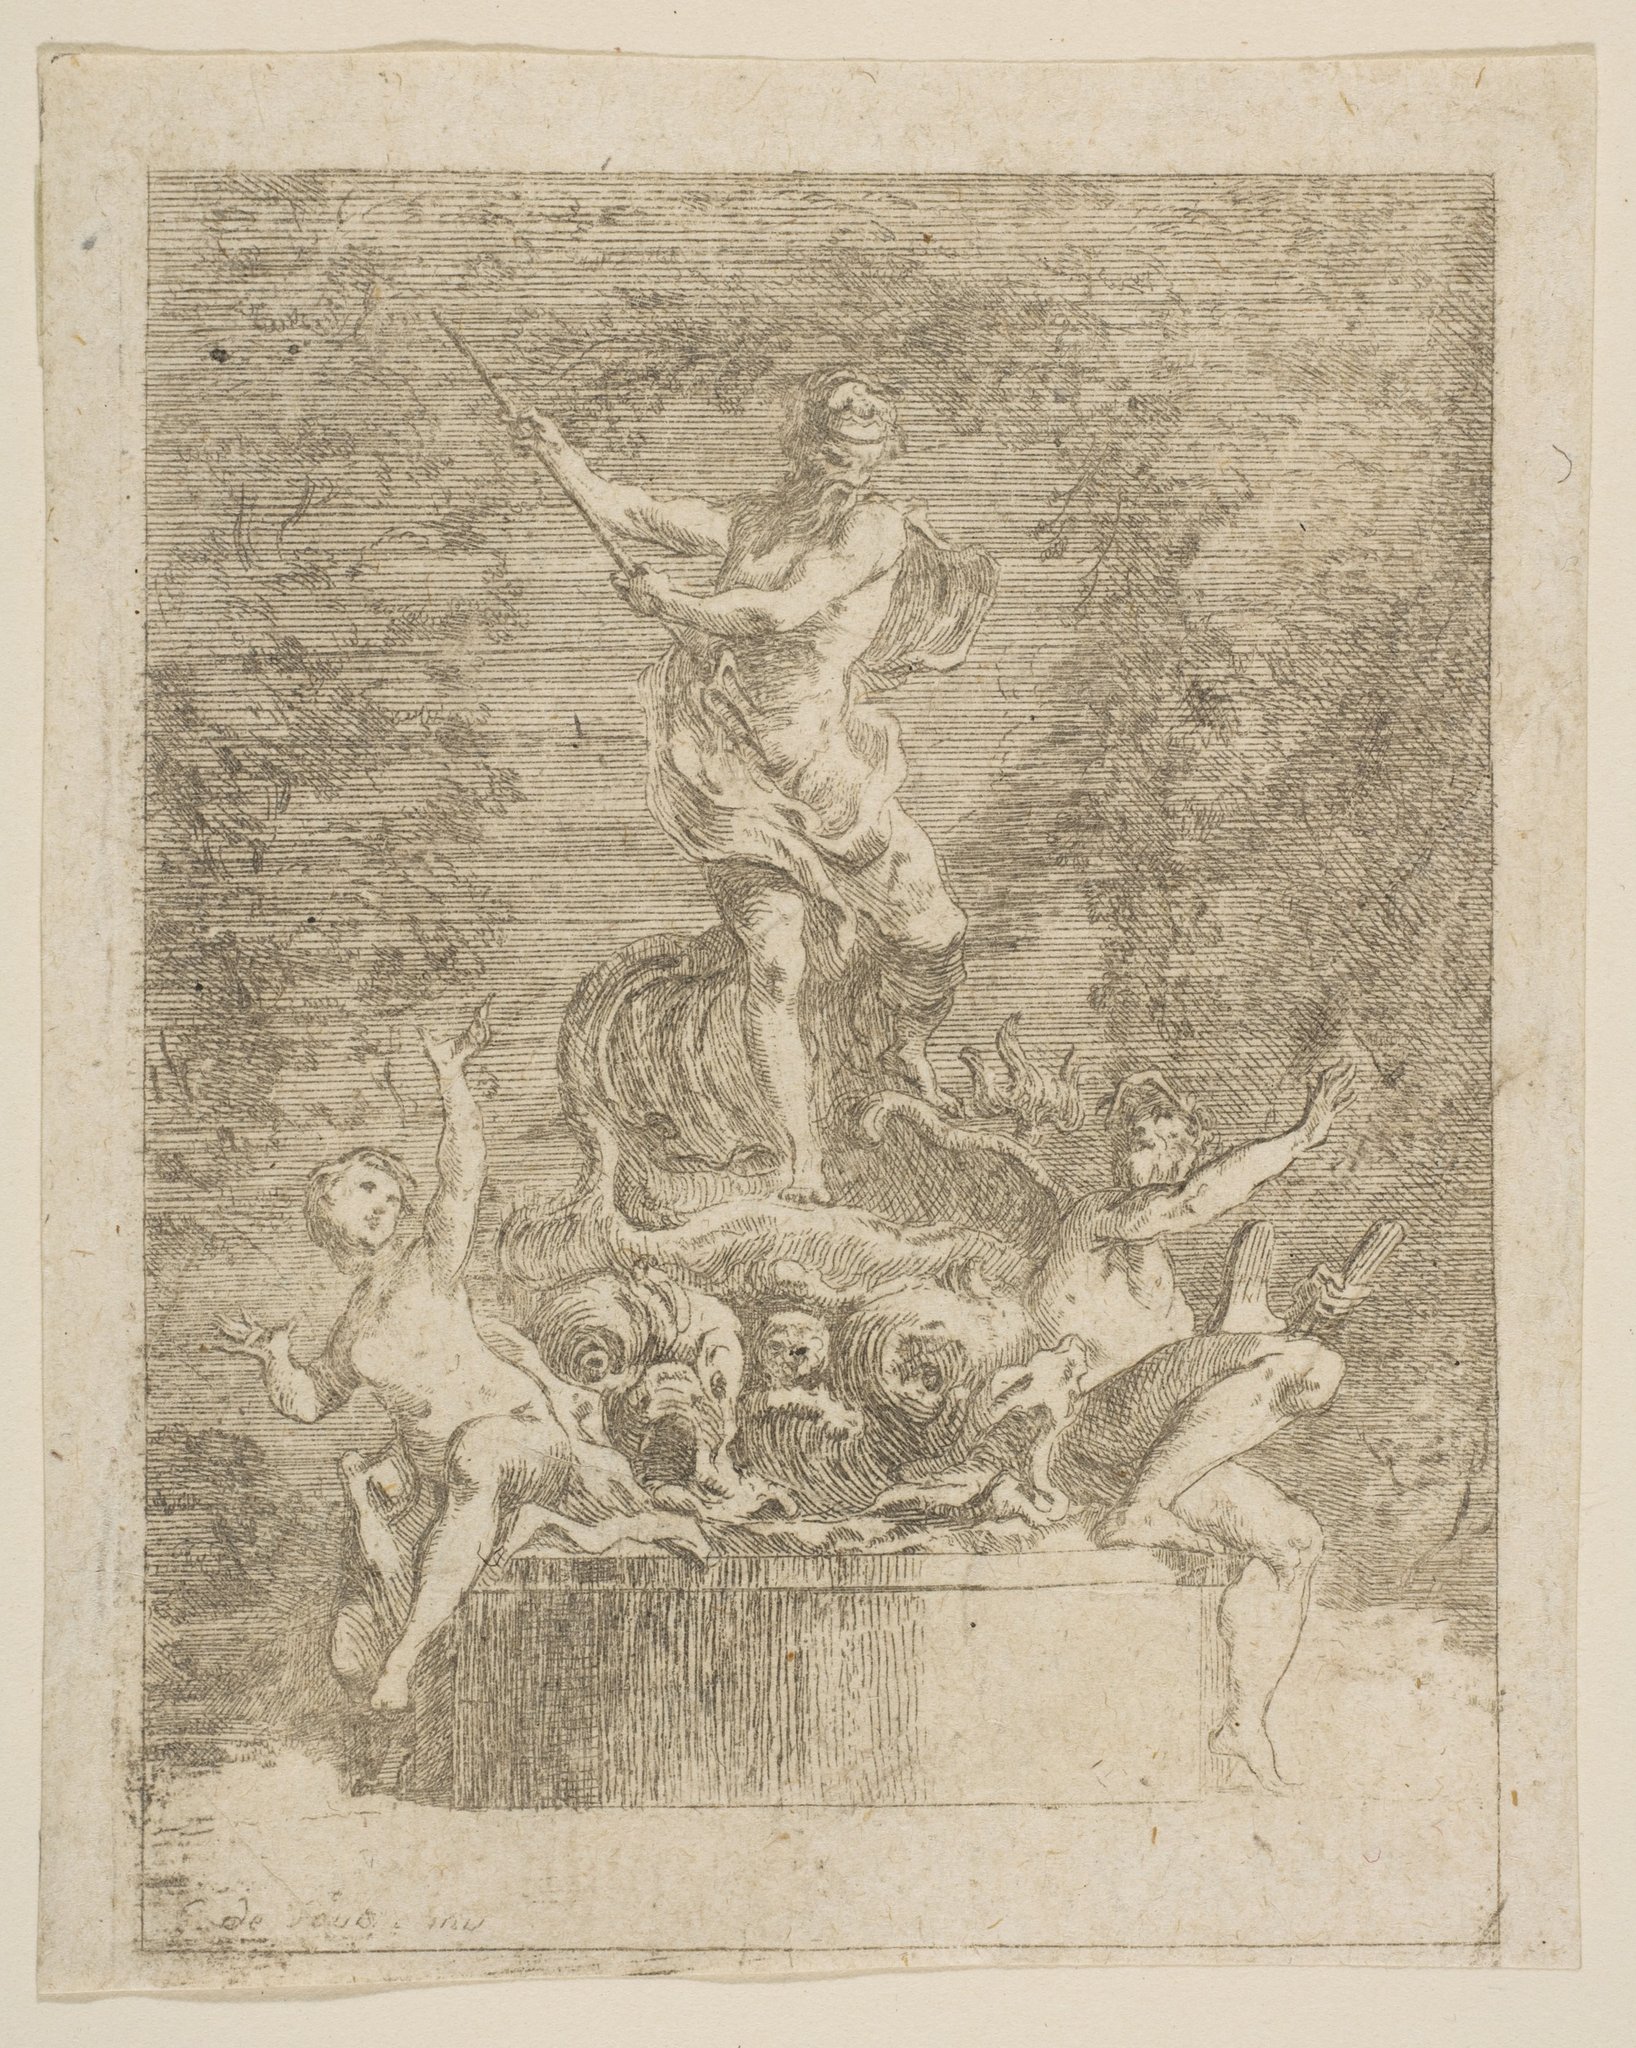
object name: print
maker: gabriel de saint-aubin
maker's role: artist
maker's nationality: french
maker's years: 1724-1780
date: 1767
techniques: etching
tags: neptune